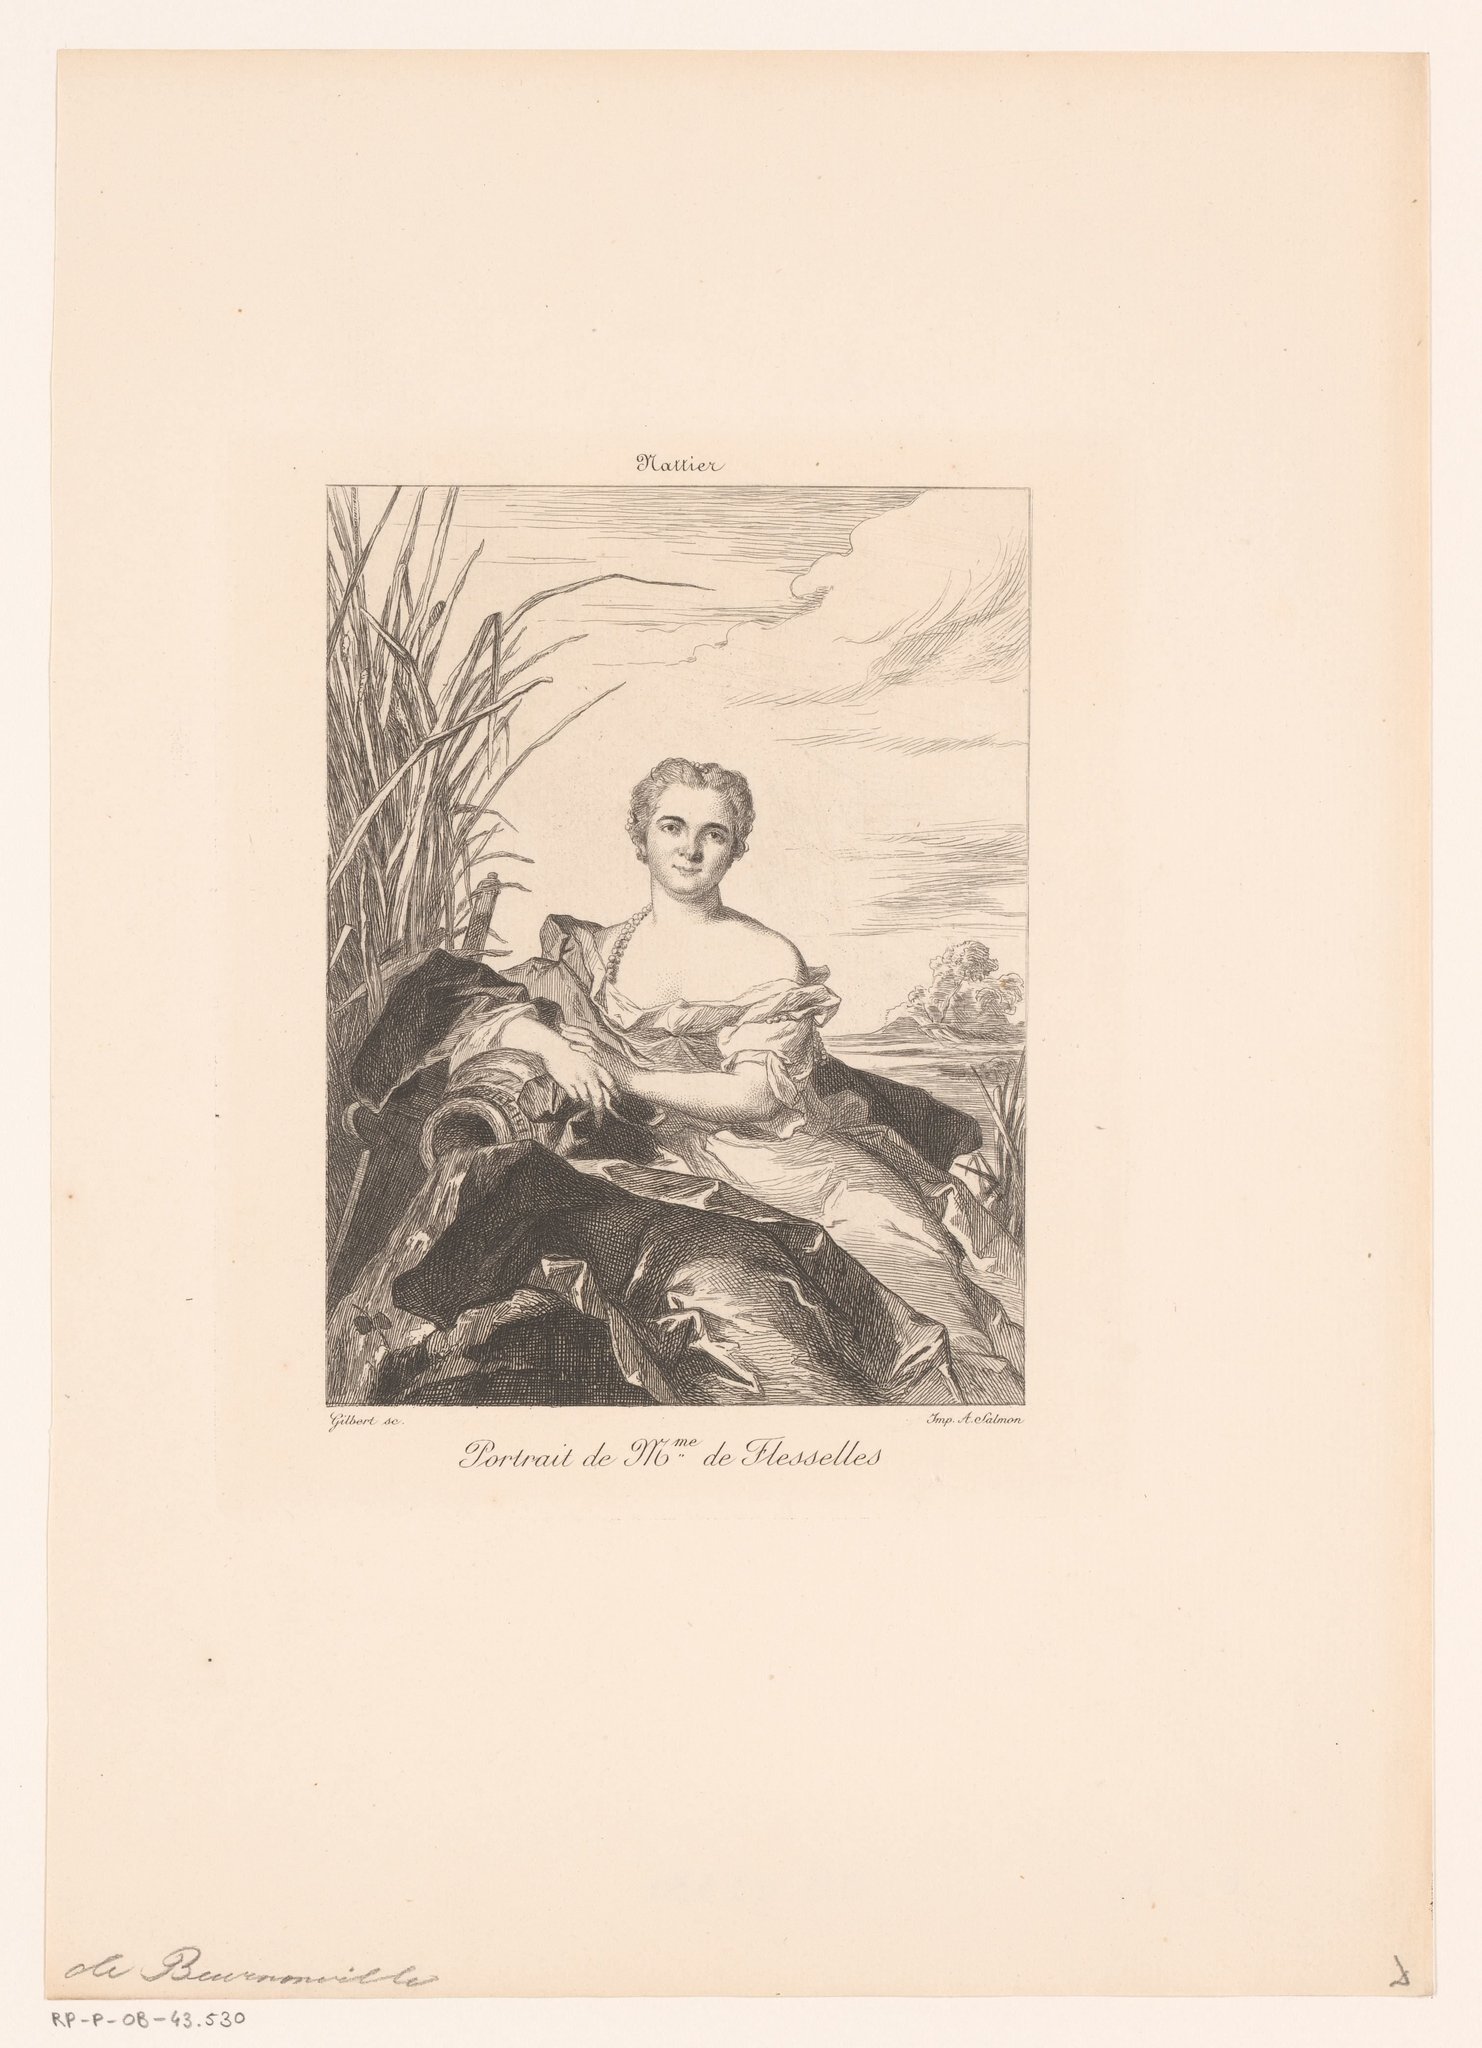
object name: book illustration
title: Portret van Elisabeth de Flesselles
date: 1881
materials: paper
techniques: etching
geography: paris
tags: historical persons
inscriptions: collector's mark: Lugt 2228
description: Prent afkomstig uit een veilingcatalogus: "Catalogue des Tableaux anciens composant la très importante collection de Monsieur le Baron de Beurnonville", uitgegeven in 1881 te Parijs door Pillet en Dumoulin. De veiling vond plaats op 9 tot en met 14 en 16 mei 1881.